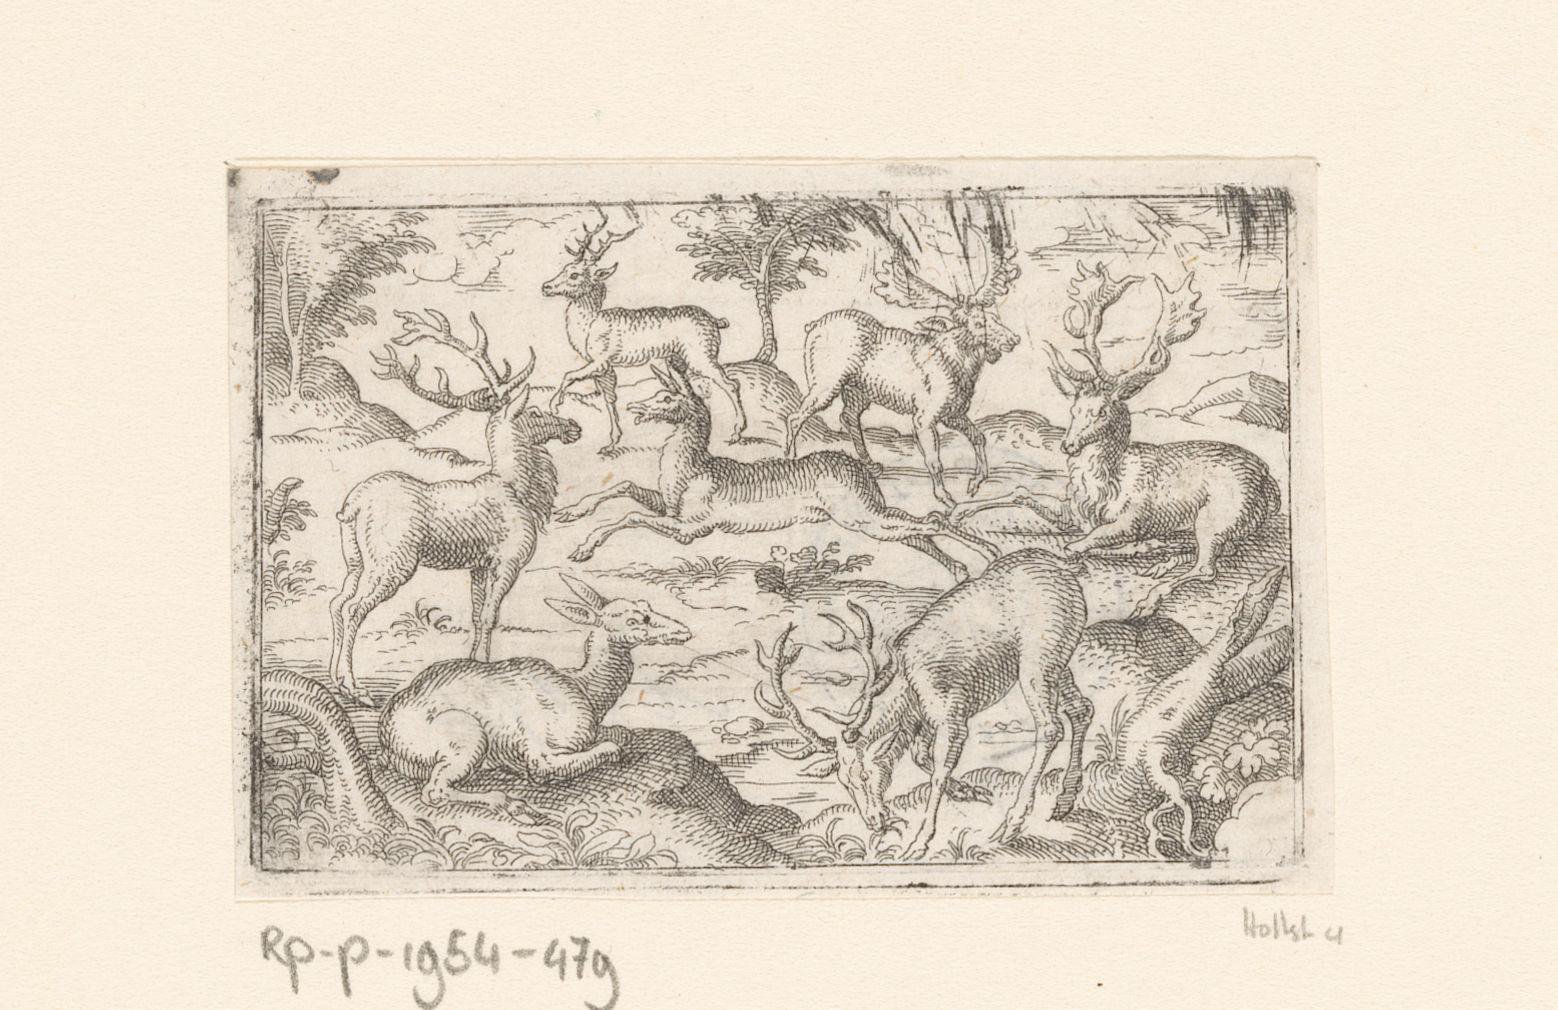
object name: print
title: Dieren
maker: stephan herman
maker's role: print maker, publisher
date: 1578-1596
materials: paper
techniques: etching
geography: ansbach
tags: hoofed animals: deer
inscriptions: collector's mark: Lugt 2542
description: Onderdeel van een serie van tien prenten van dieren.